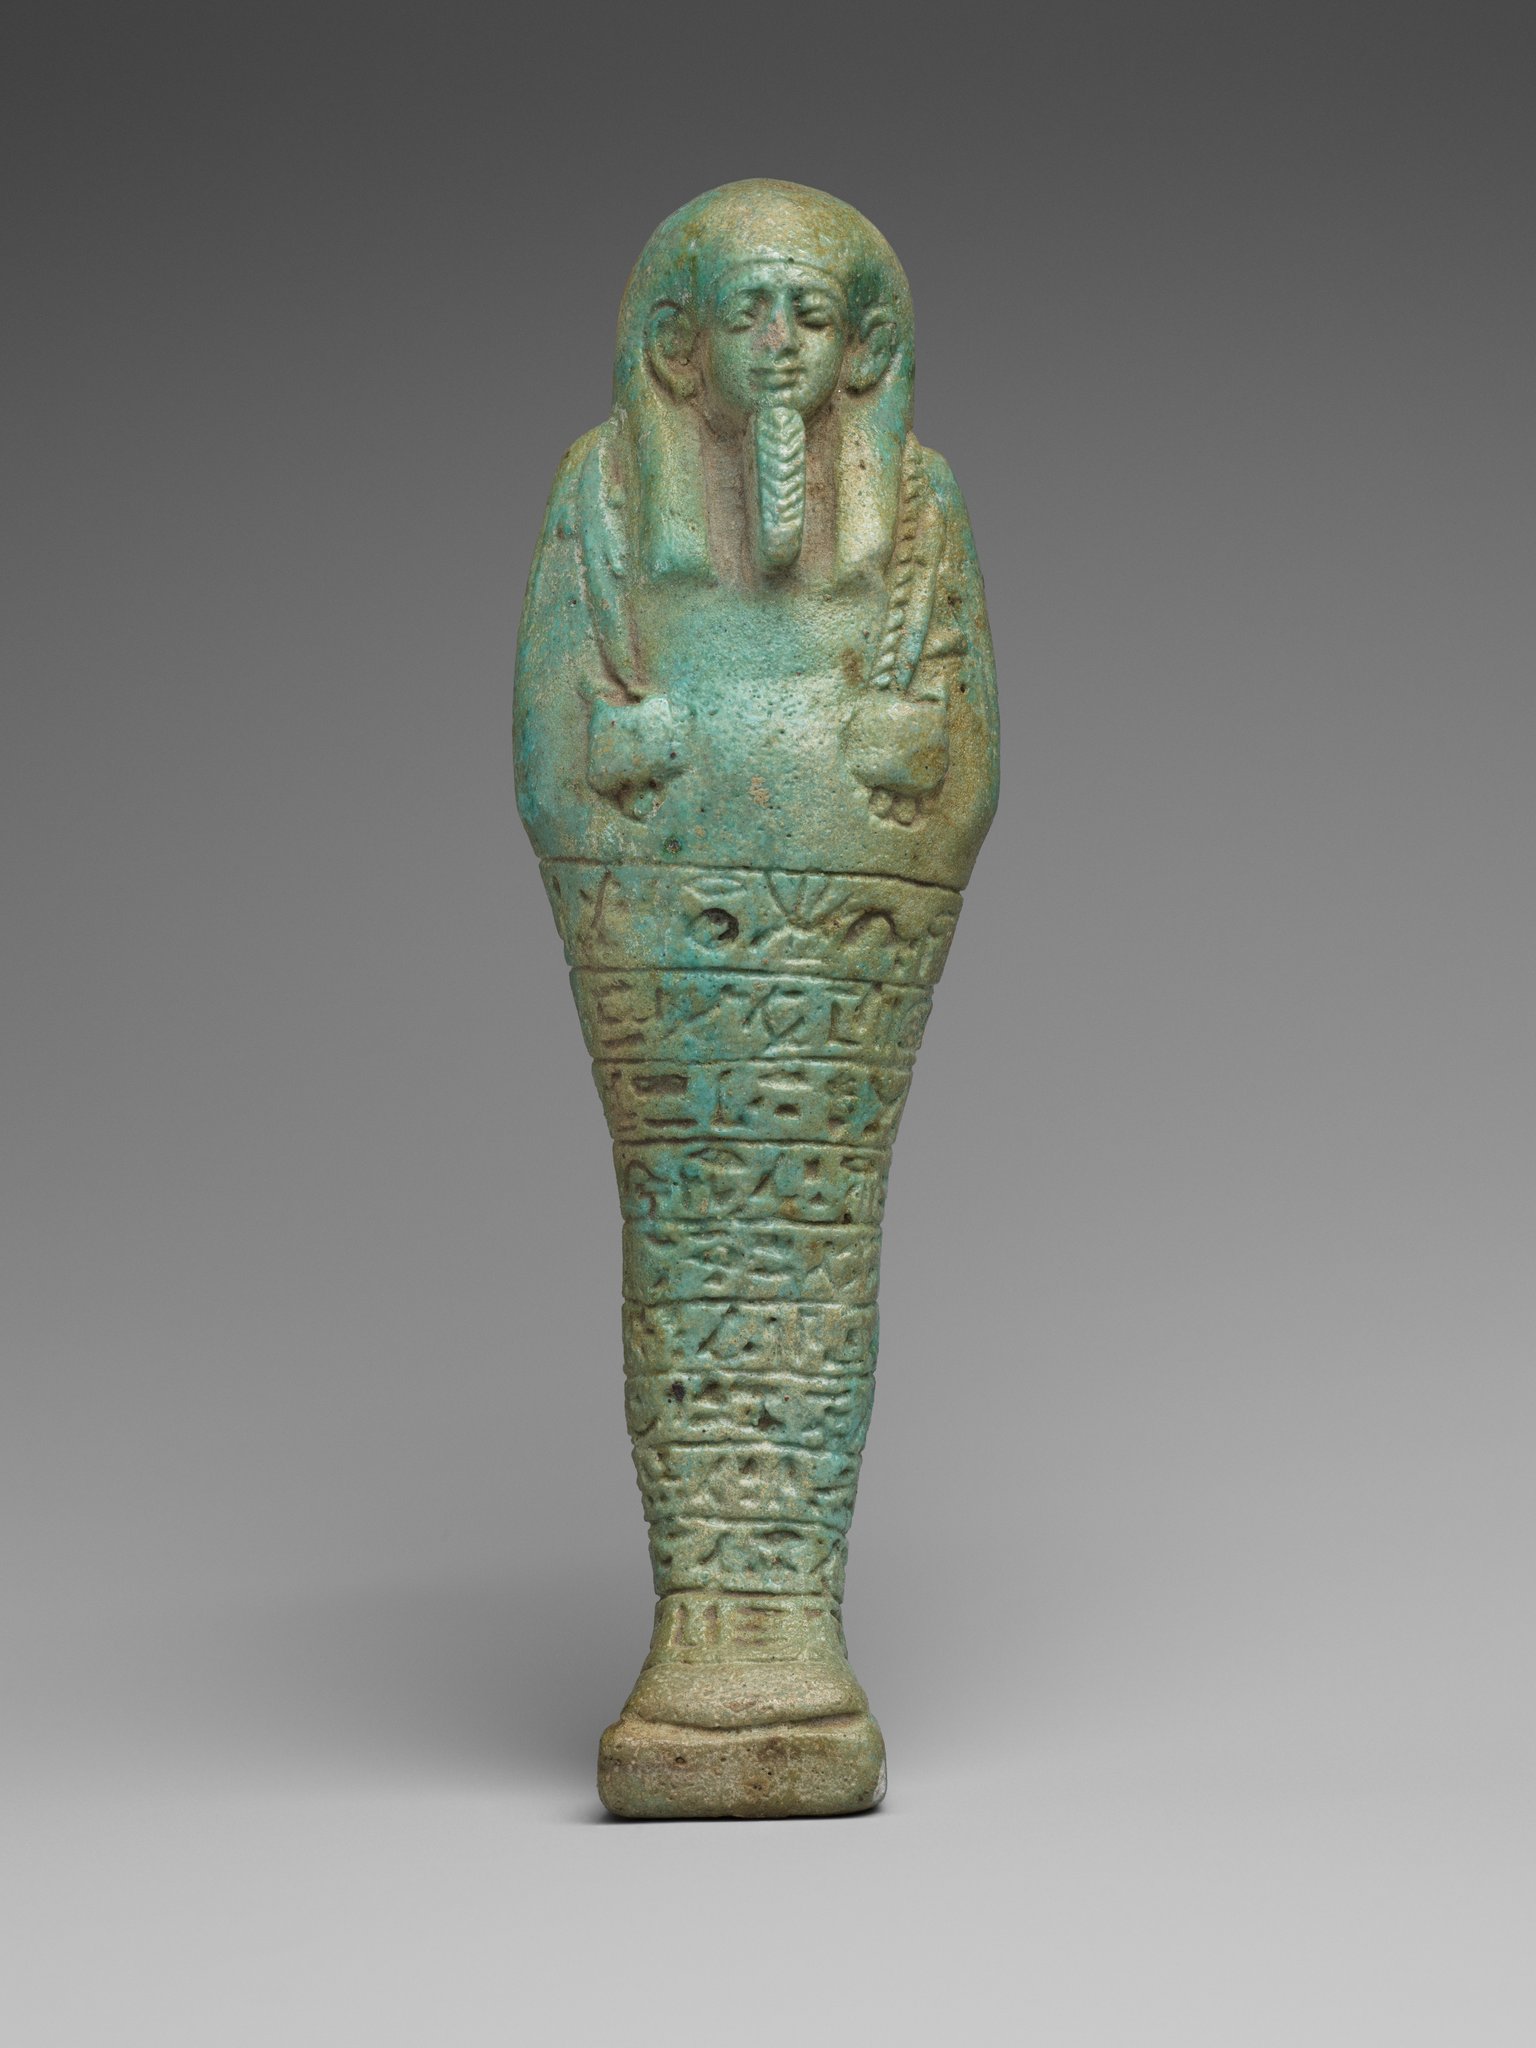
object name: shabti, pa abu meh, psamtik seneb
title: Shabti of the Treasurer of Lower Egypt Pa-abumeh, called Psamtik-seneb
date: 595-380 BCE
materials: faience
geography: egypt